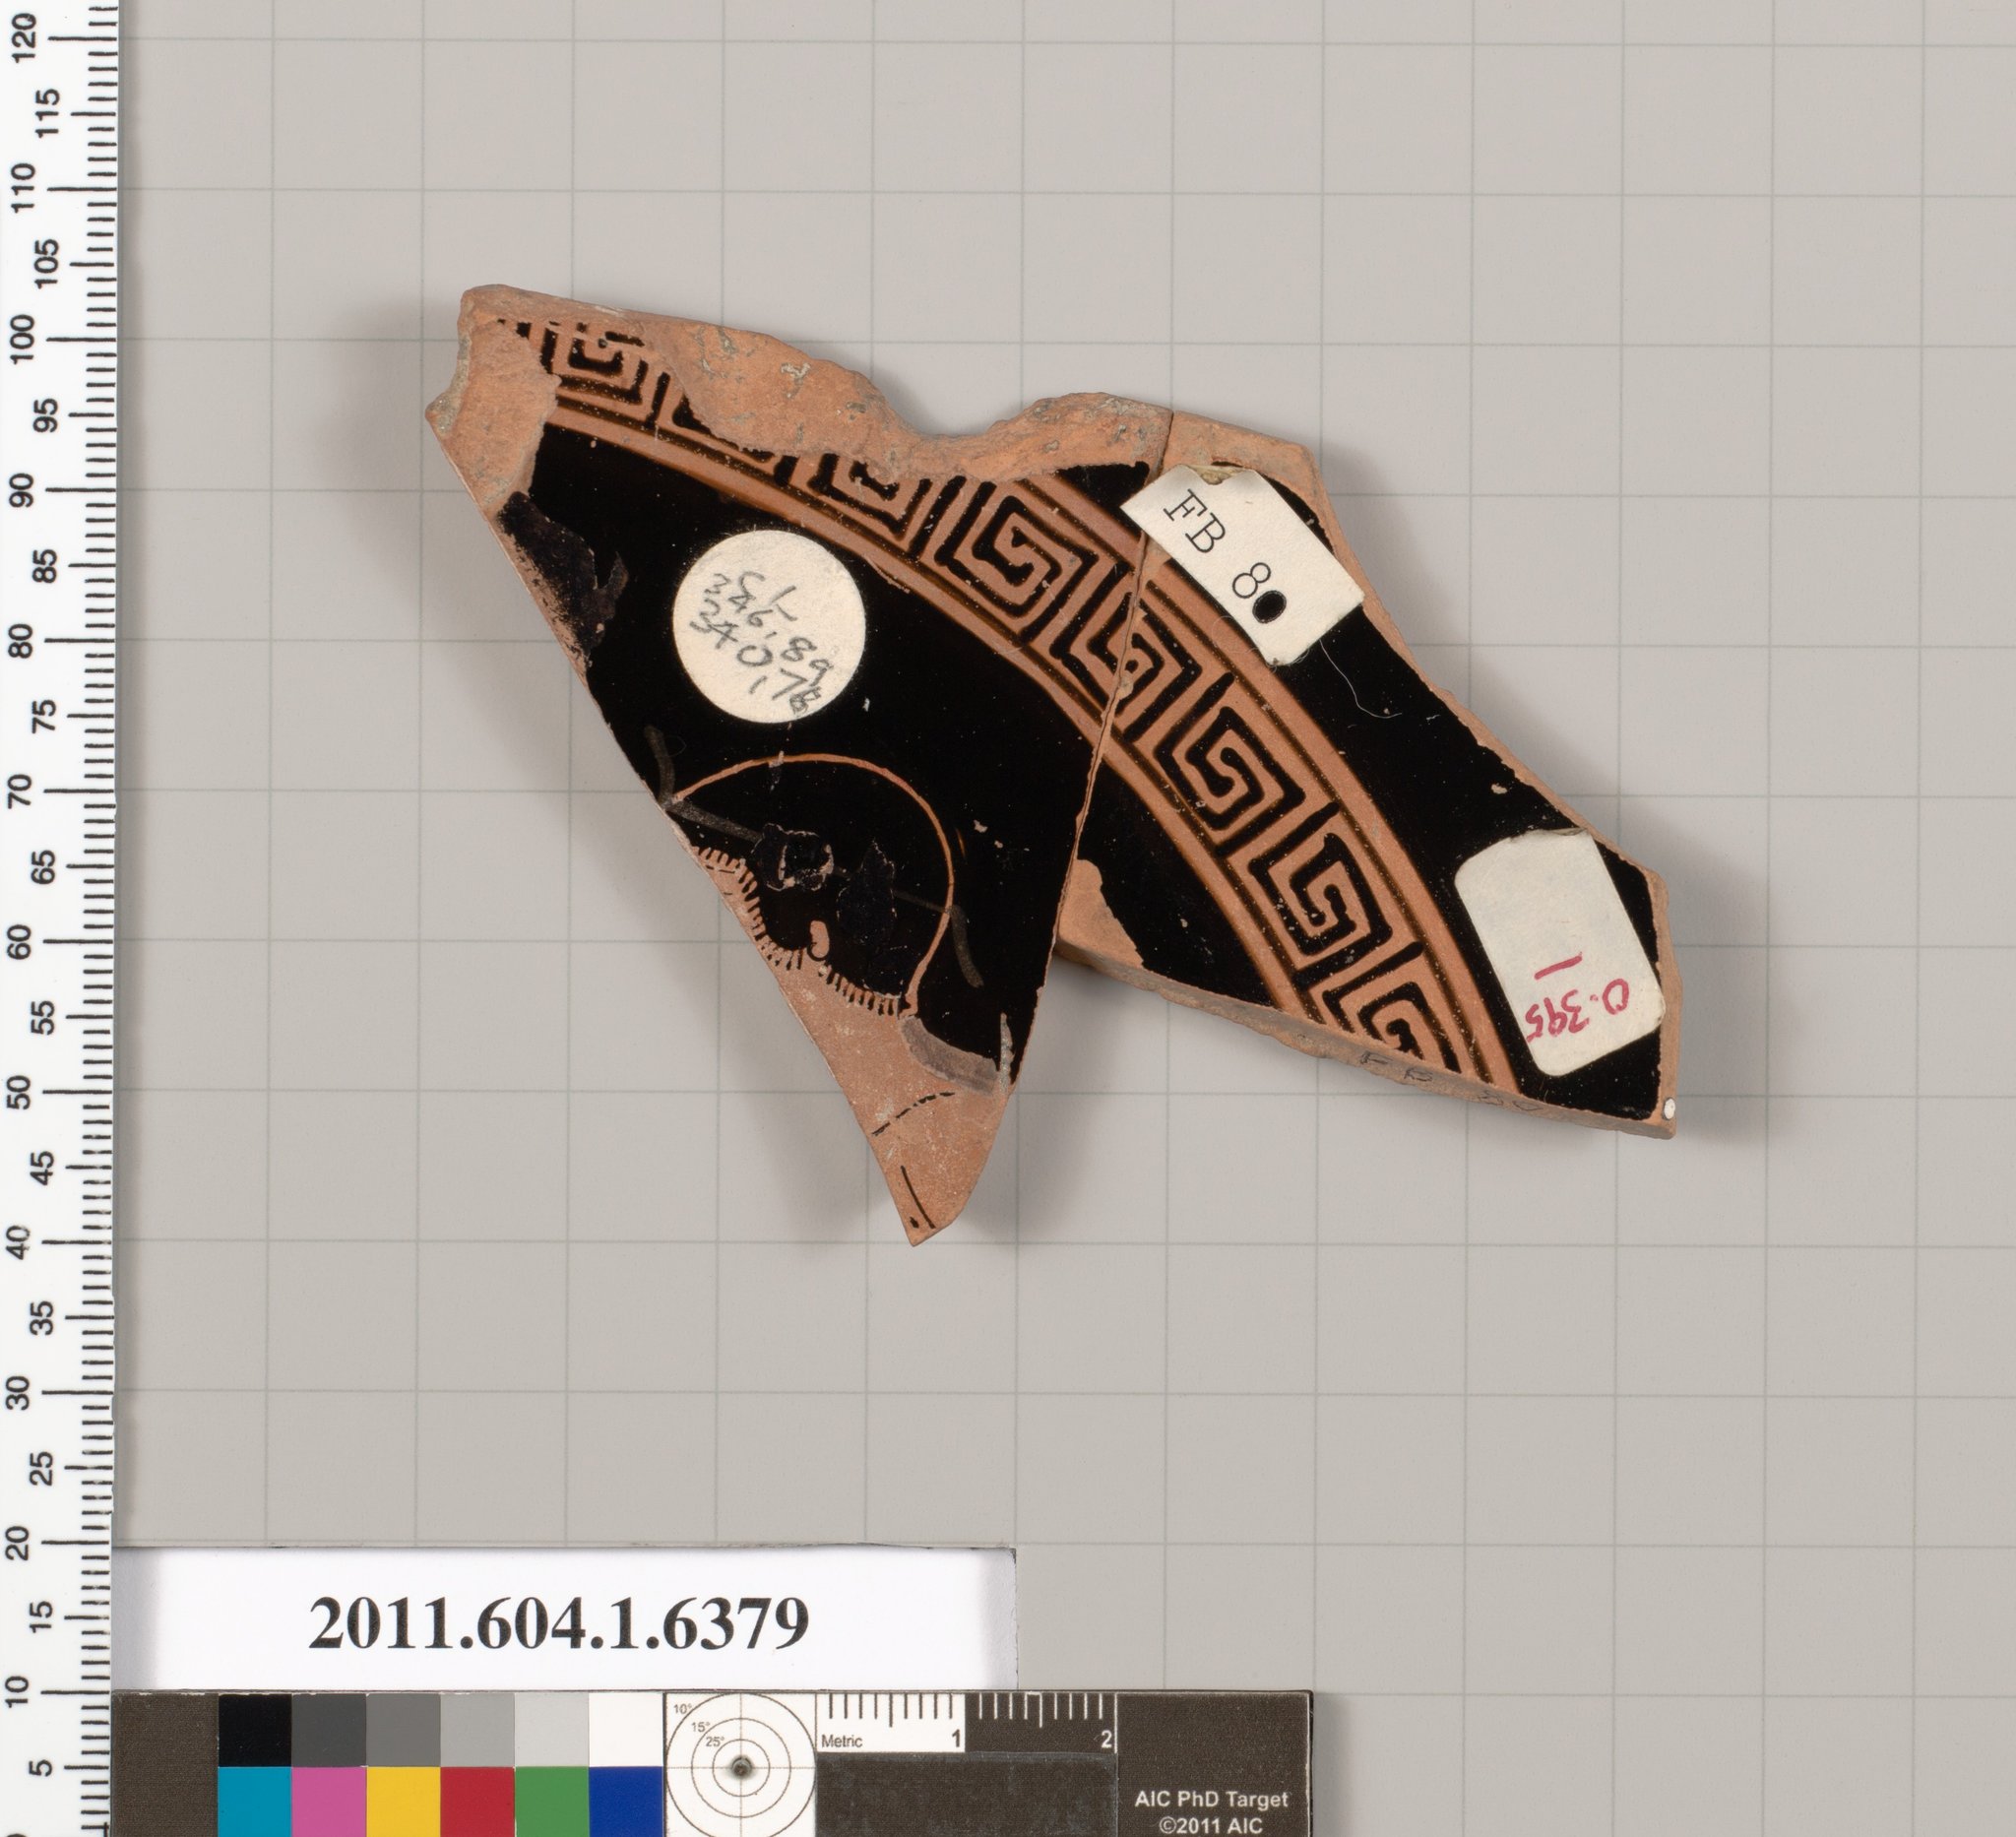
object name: kylix fragment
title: Terracotta fragment of a kylix (drinking cup)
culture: greek, attic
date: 490-480 BCE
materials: terracotta